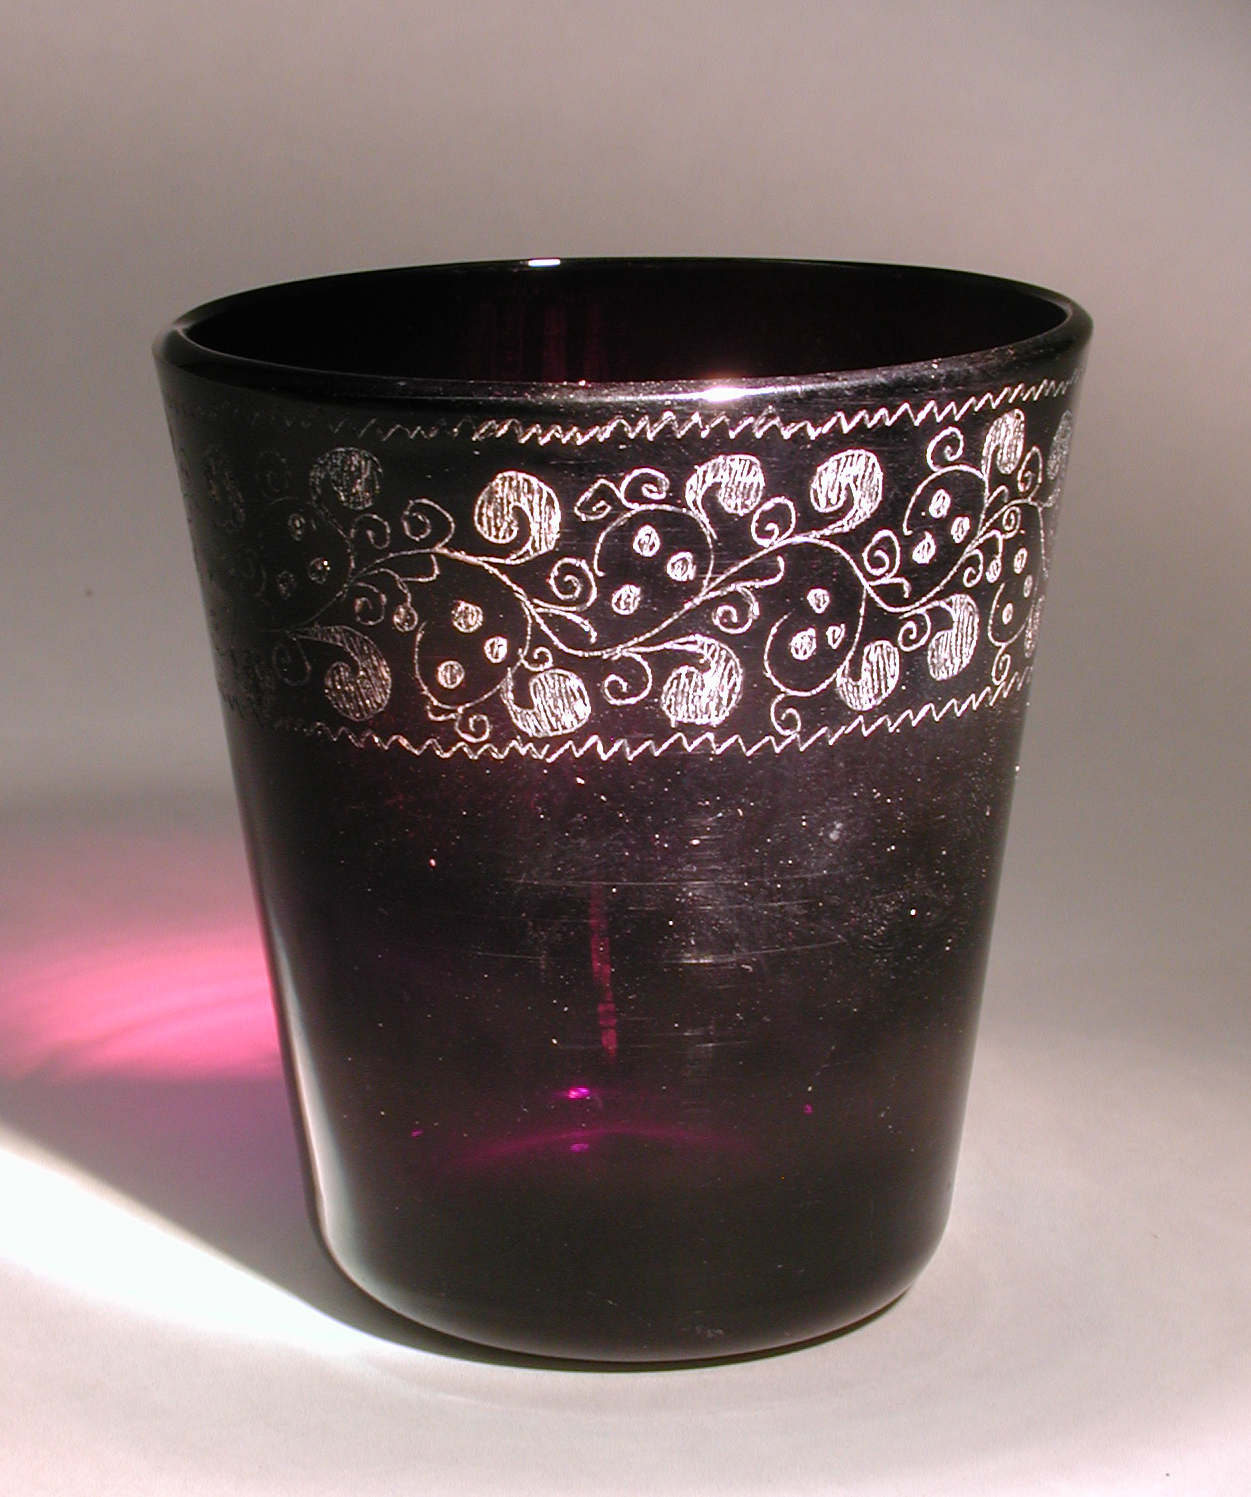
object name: beaker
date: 1601-1633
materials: glass